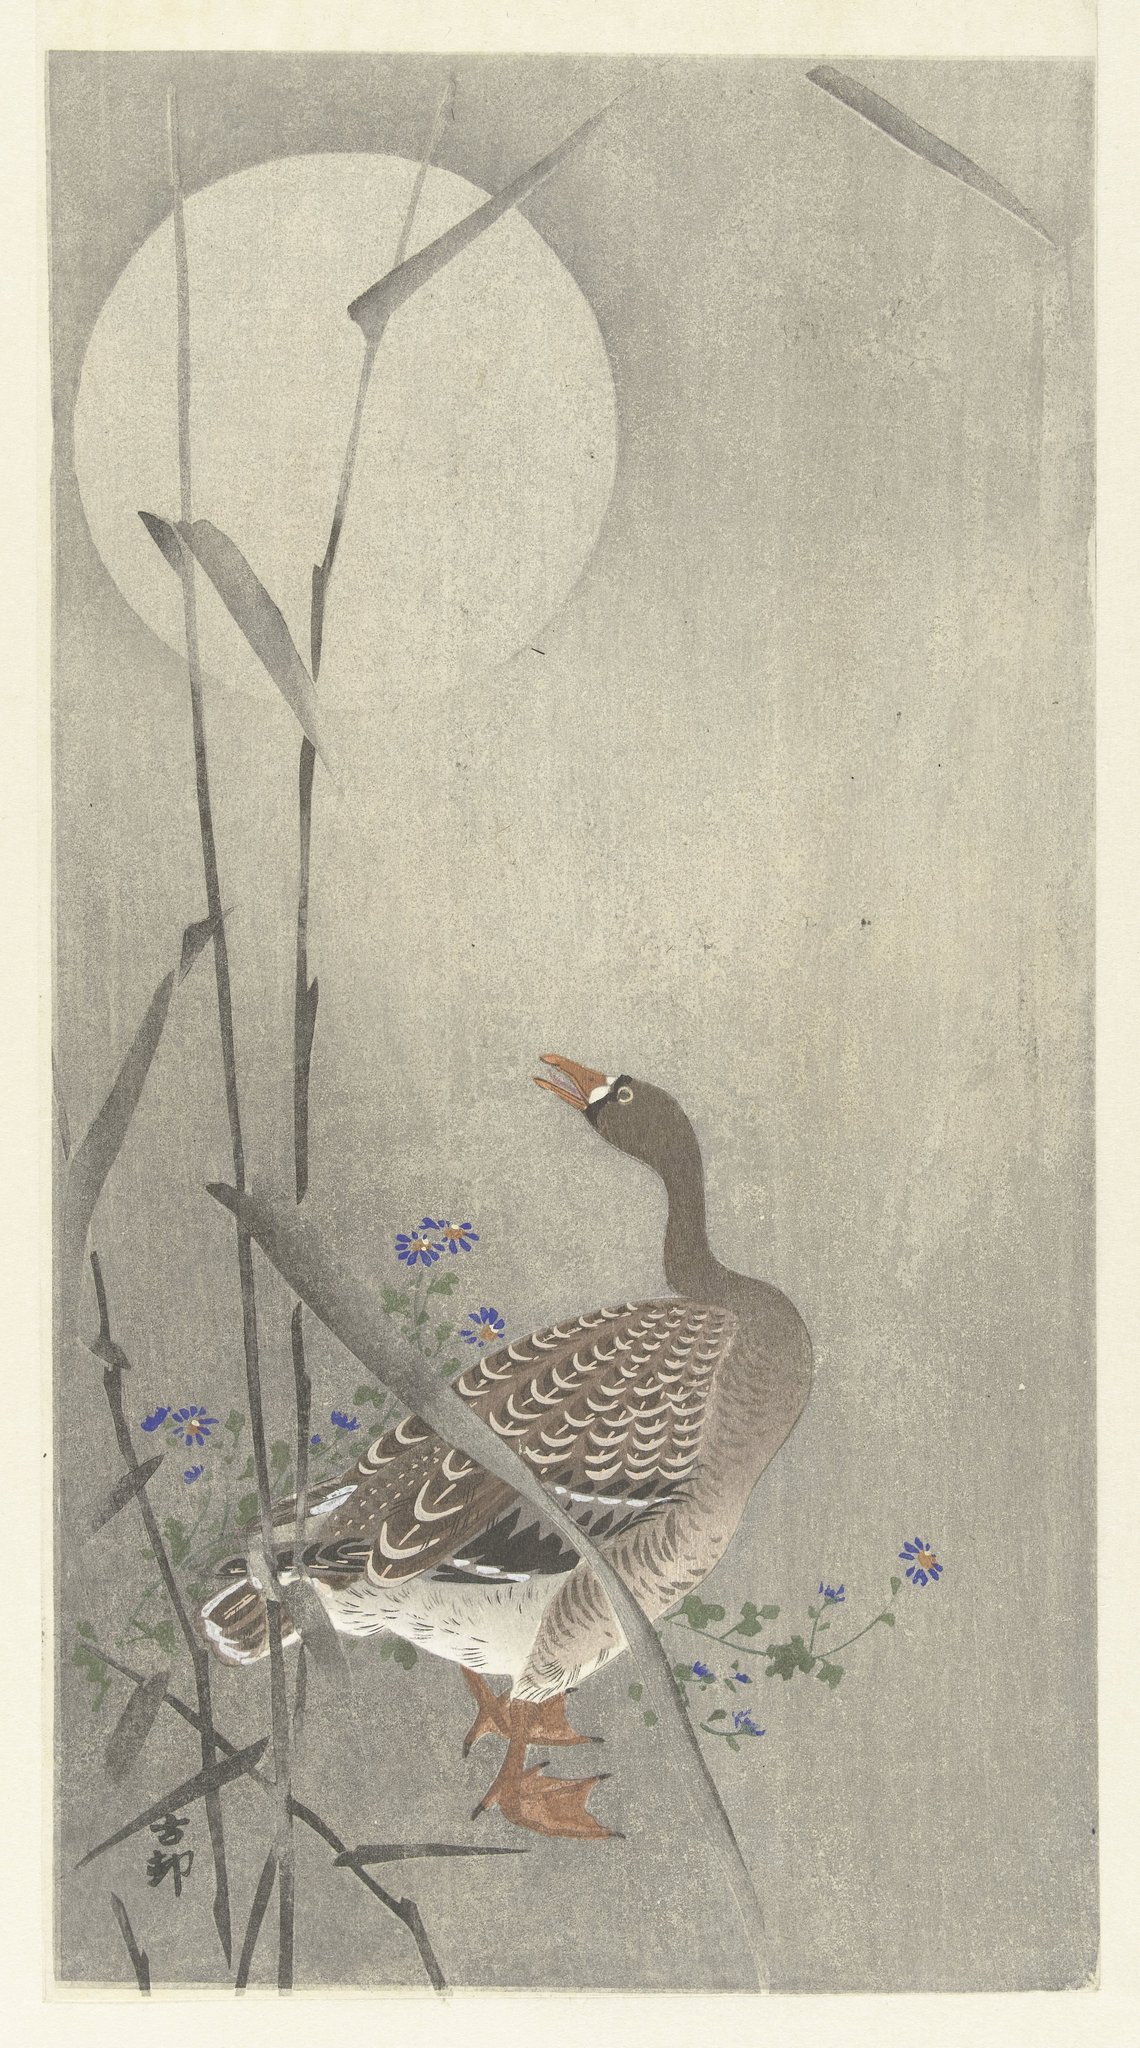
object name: print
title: Gans bij volle maan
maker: ohara koson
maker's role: print maker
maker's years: 1877-1945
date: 1900-1936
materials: paper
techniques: woodcut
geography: japan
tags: plants; vegetation, full moon, water-birds: goose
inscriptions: collector's mark: Lugt 2228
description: Gans, naar links opkijkend, tussen riet en plant met blauwe bloemen, bij volle maan.